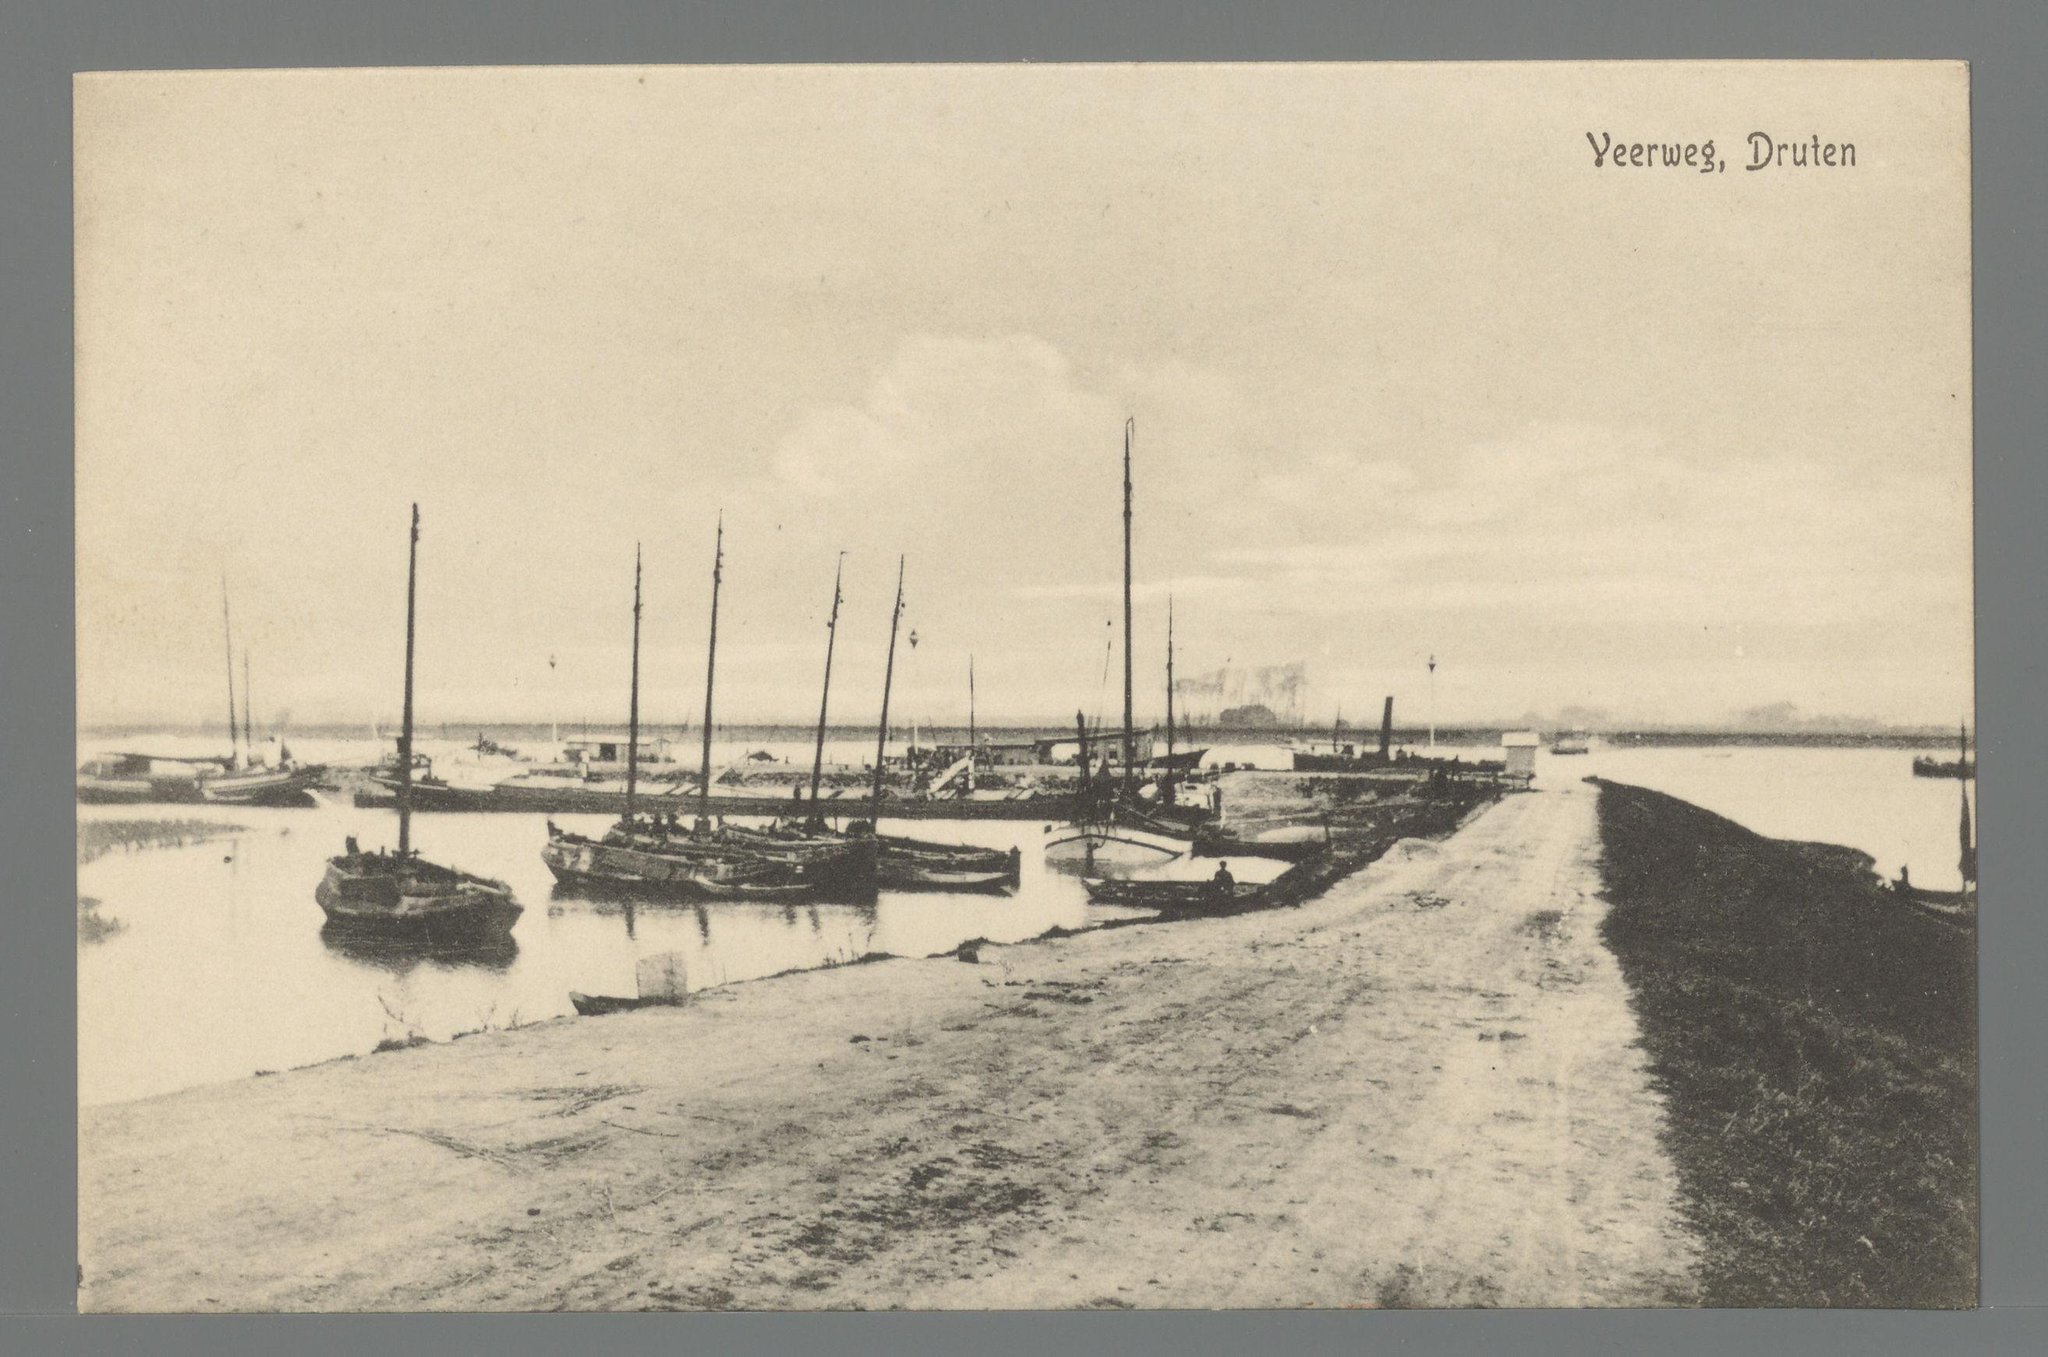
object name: ansichtkaart, prentbriefkaart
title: Veerweg, Druten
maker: Anonymous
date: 1905-1930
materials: cardboard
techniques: photograph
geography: druten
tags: sailing-ship, sailing-boat, river, road, path